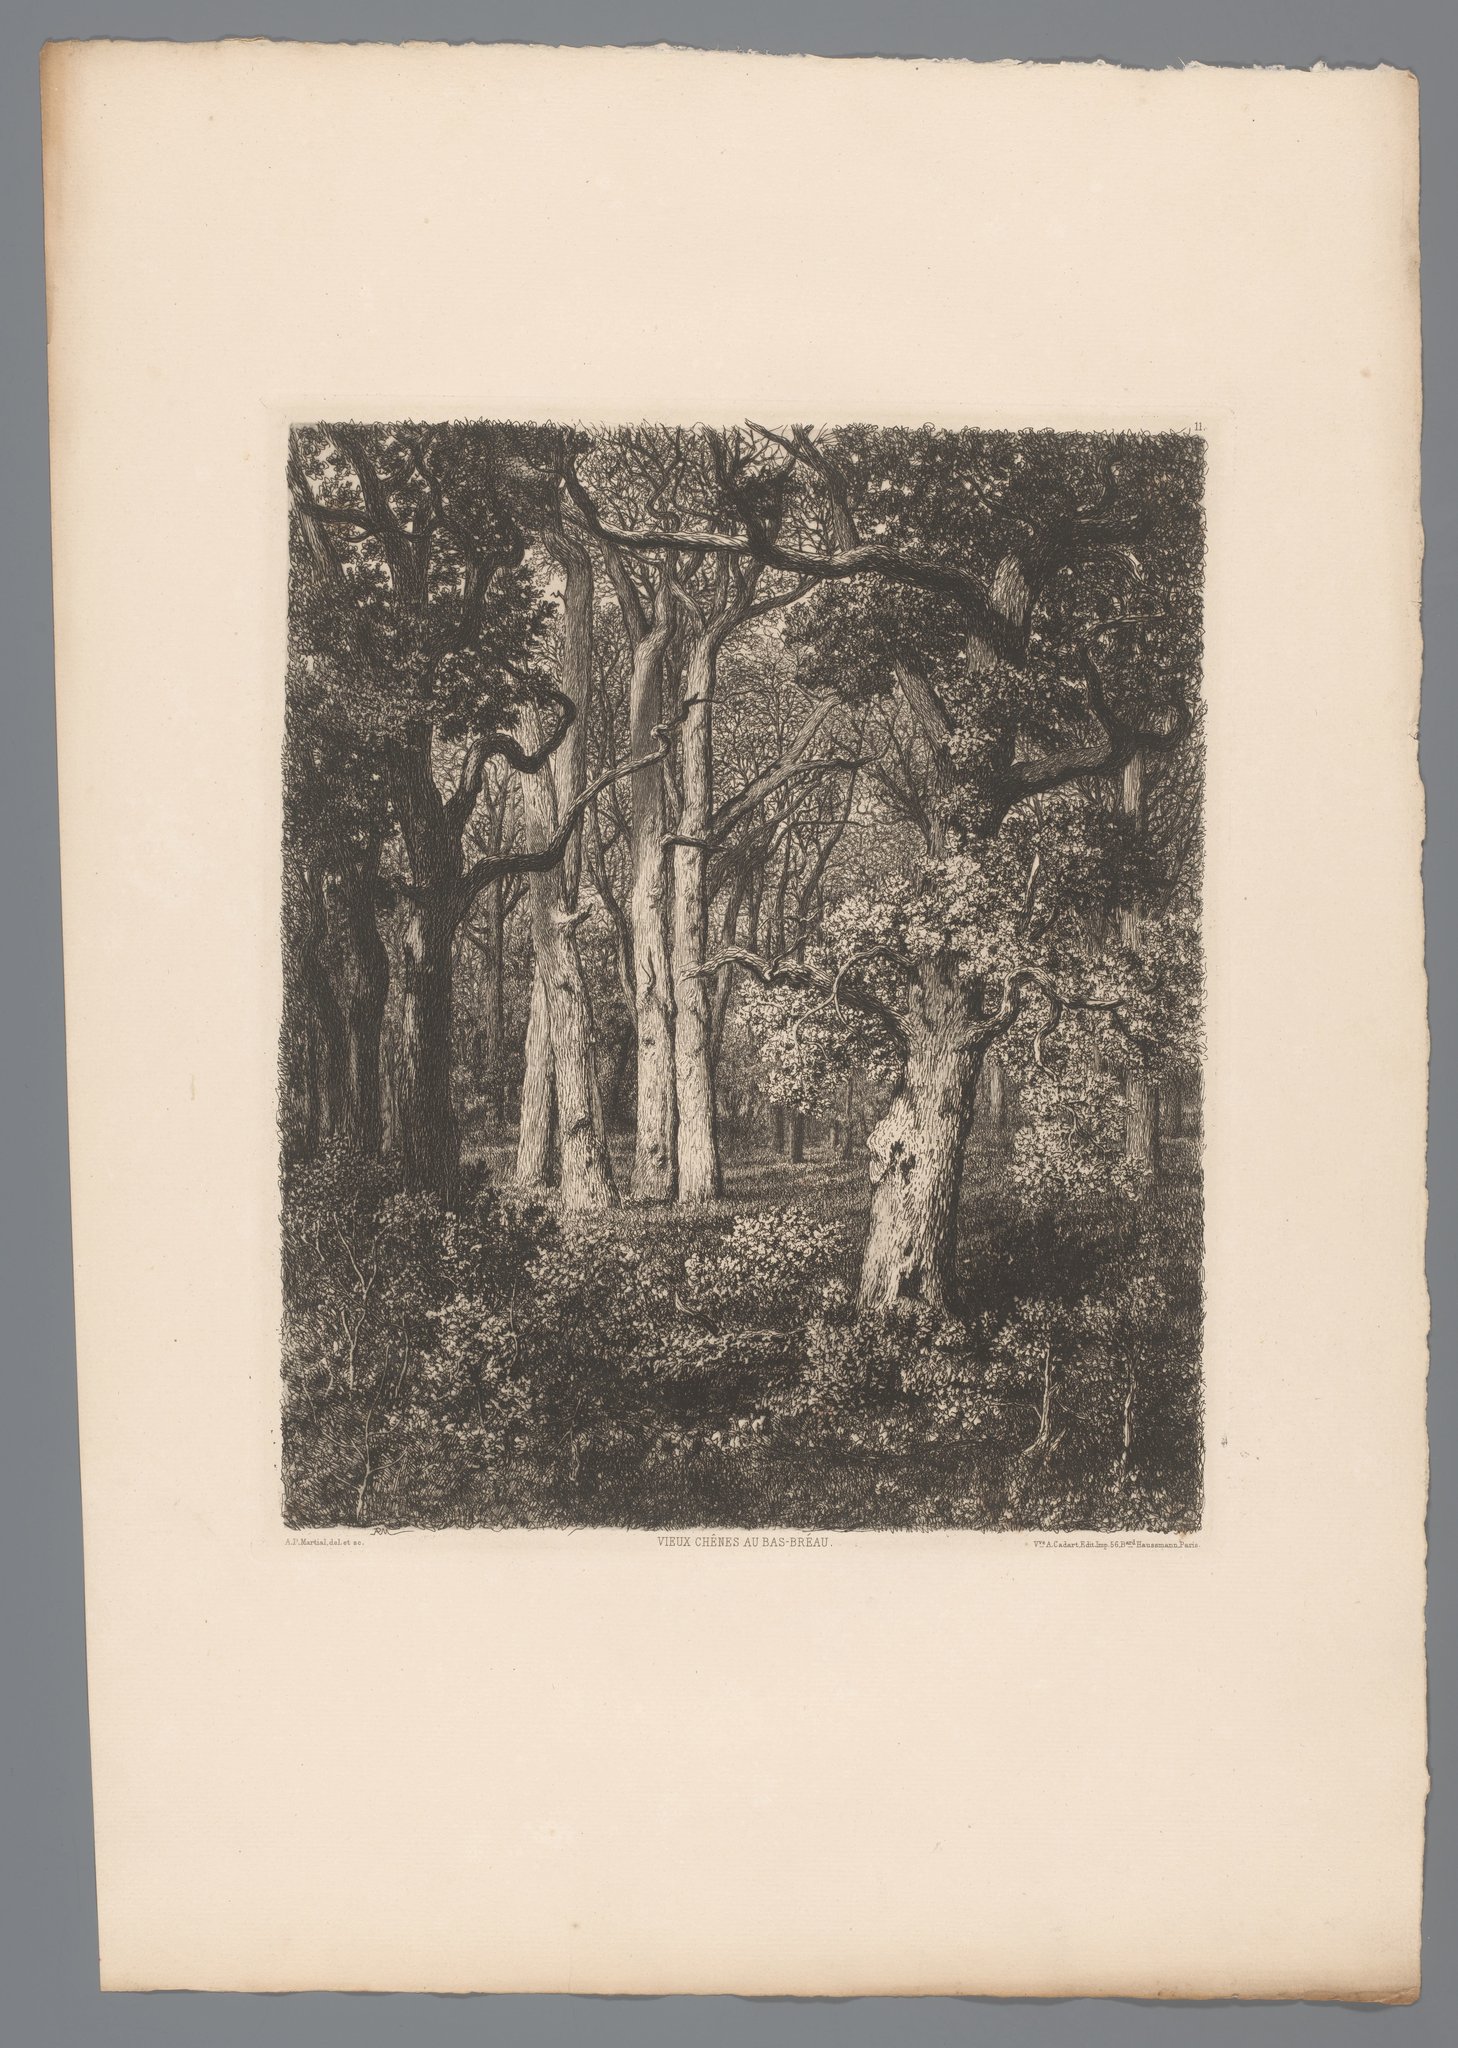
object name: print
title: Vieux chênes au Bas-Bréau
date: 1878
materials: paper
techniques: drypoint, etching, intaglio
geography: paris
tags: trees: oak, forest, wood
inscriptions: collector's mark: Lugt 2228, collector's mark: ‘AFE v S’, watermark, collector's mark: Lugt 2760